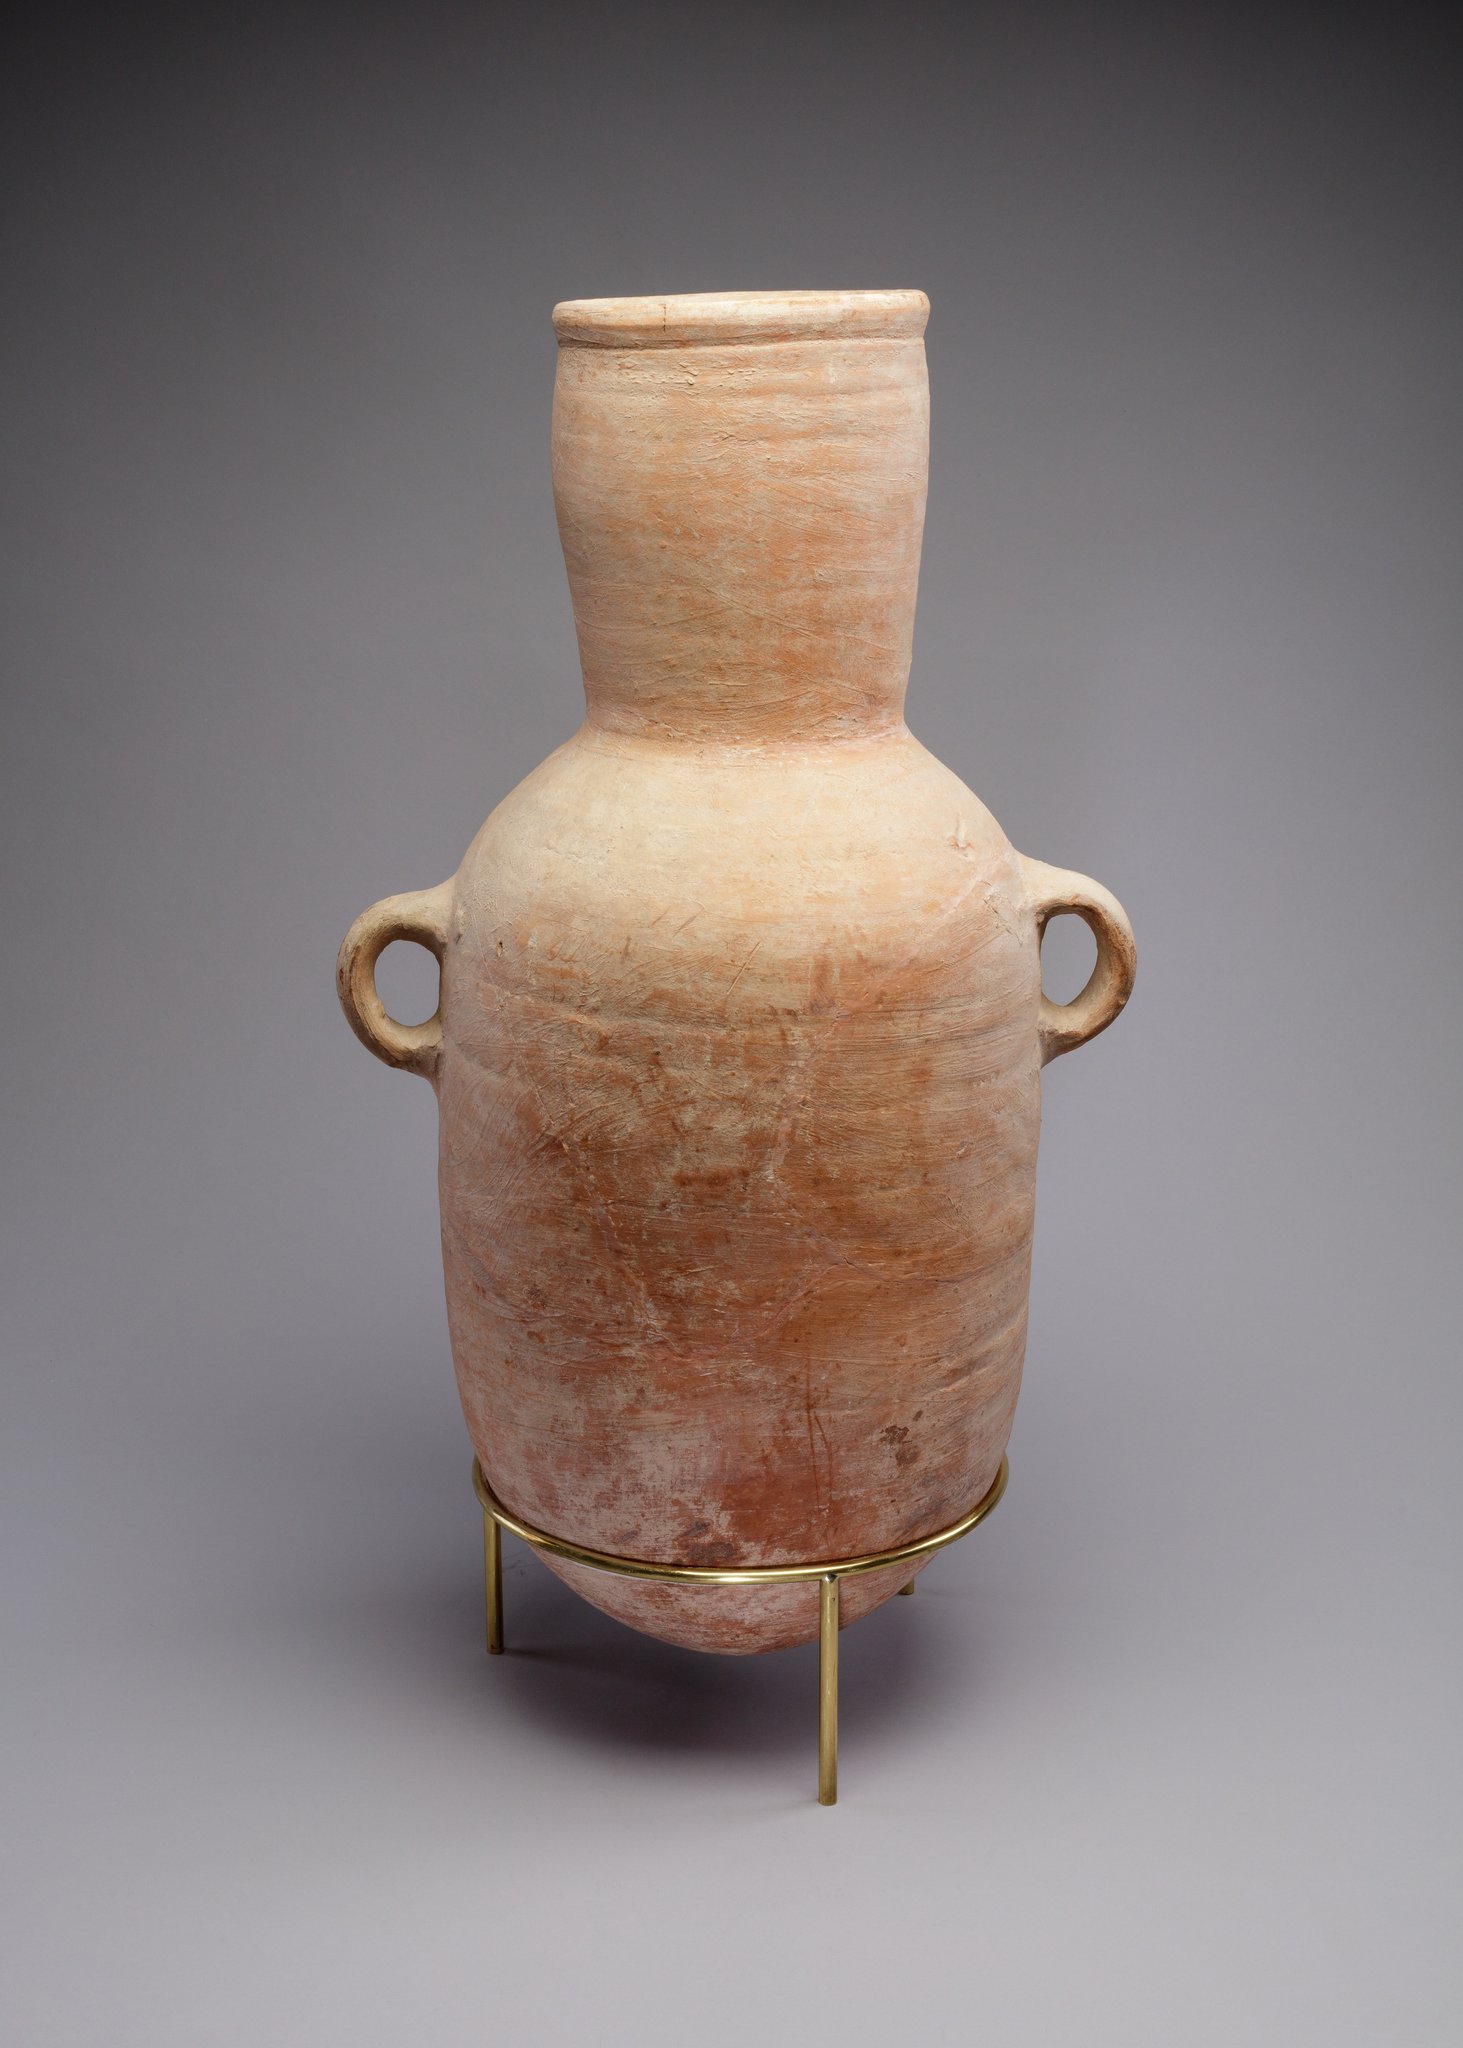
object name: jar, two handled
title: Jar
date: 1550-1186 BCE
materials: pottery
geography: egypt